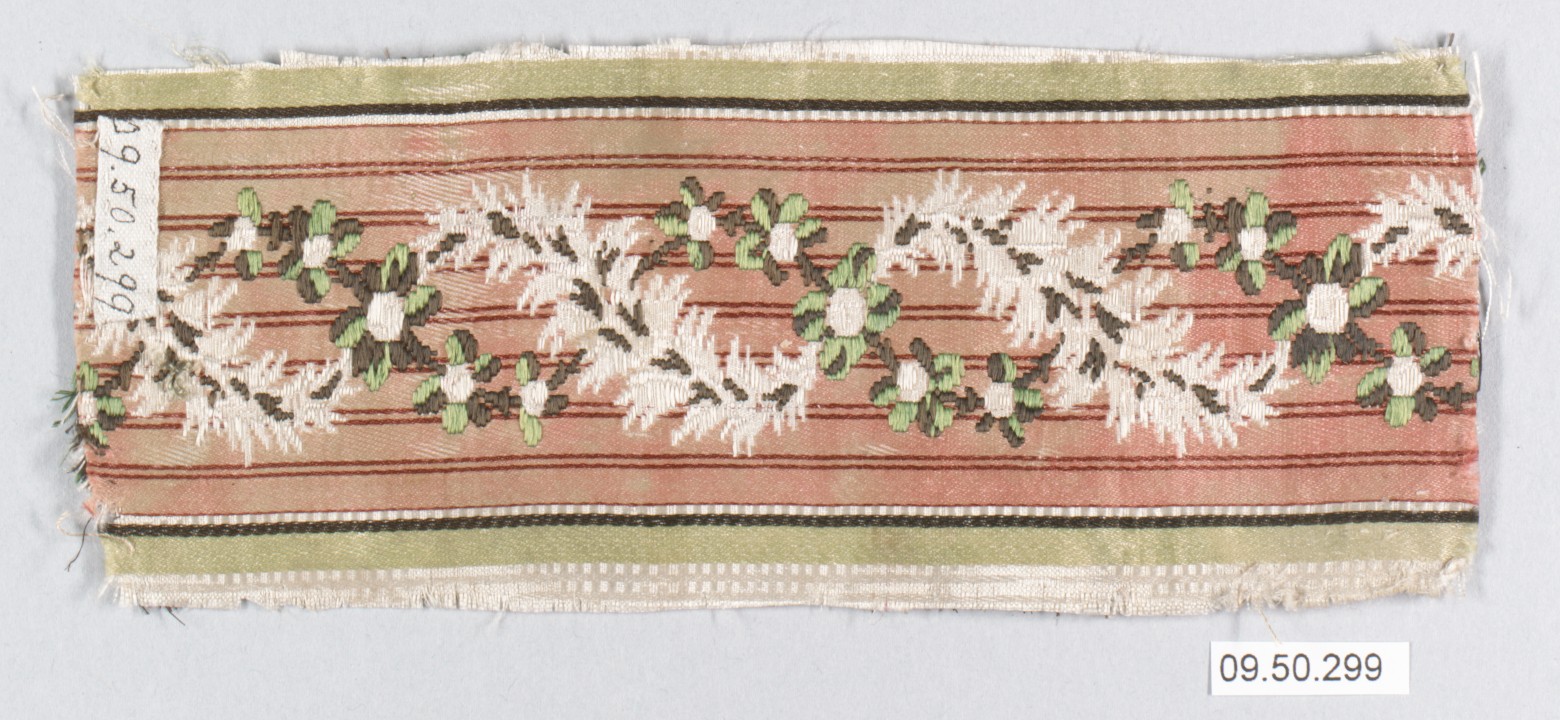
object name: ribbon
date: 1701-1800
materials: silk